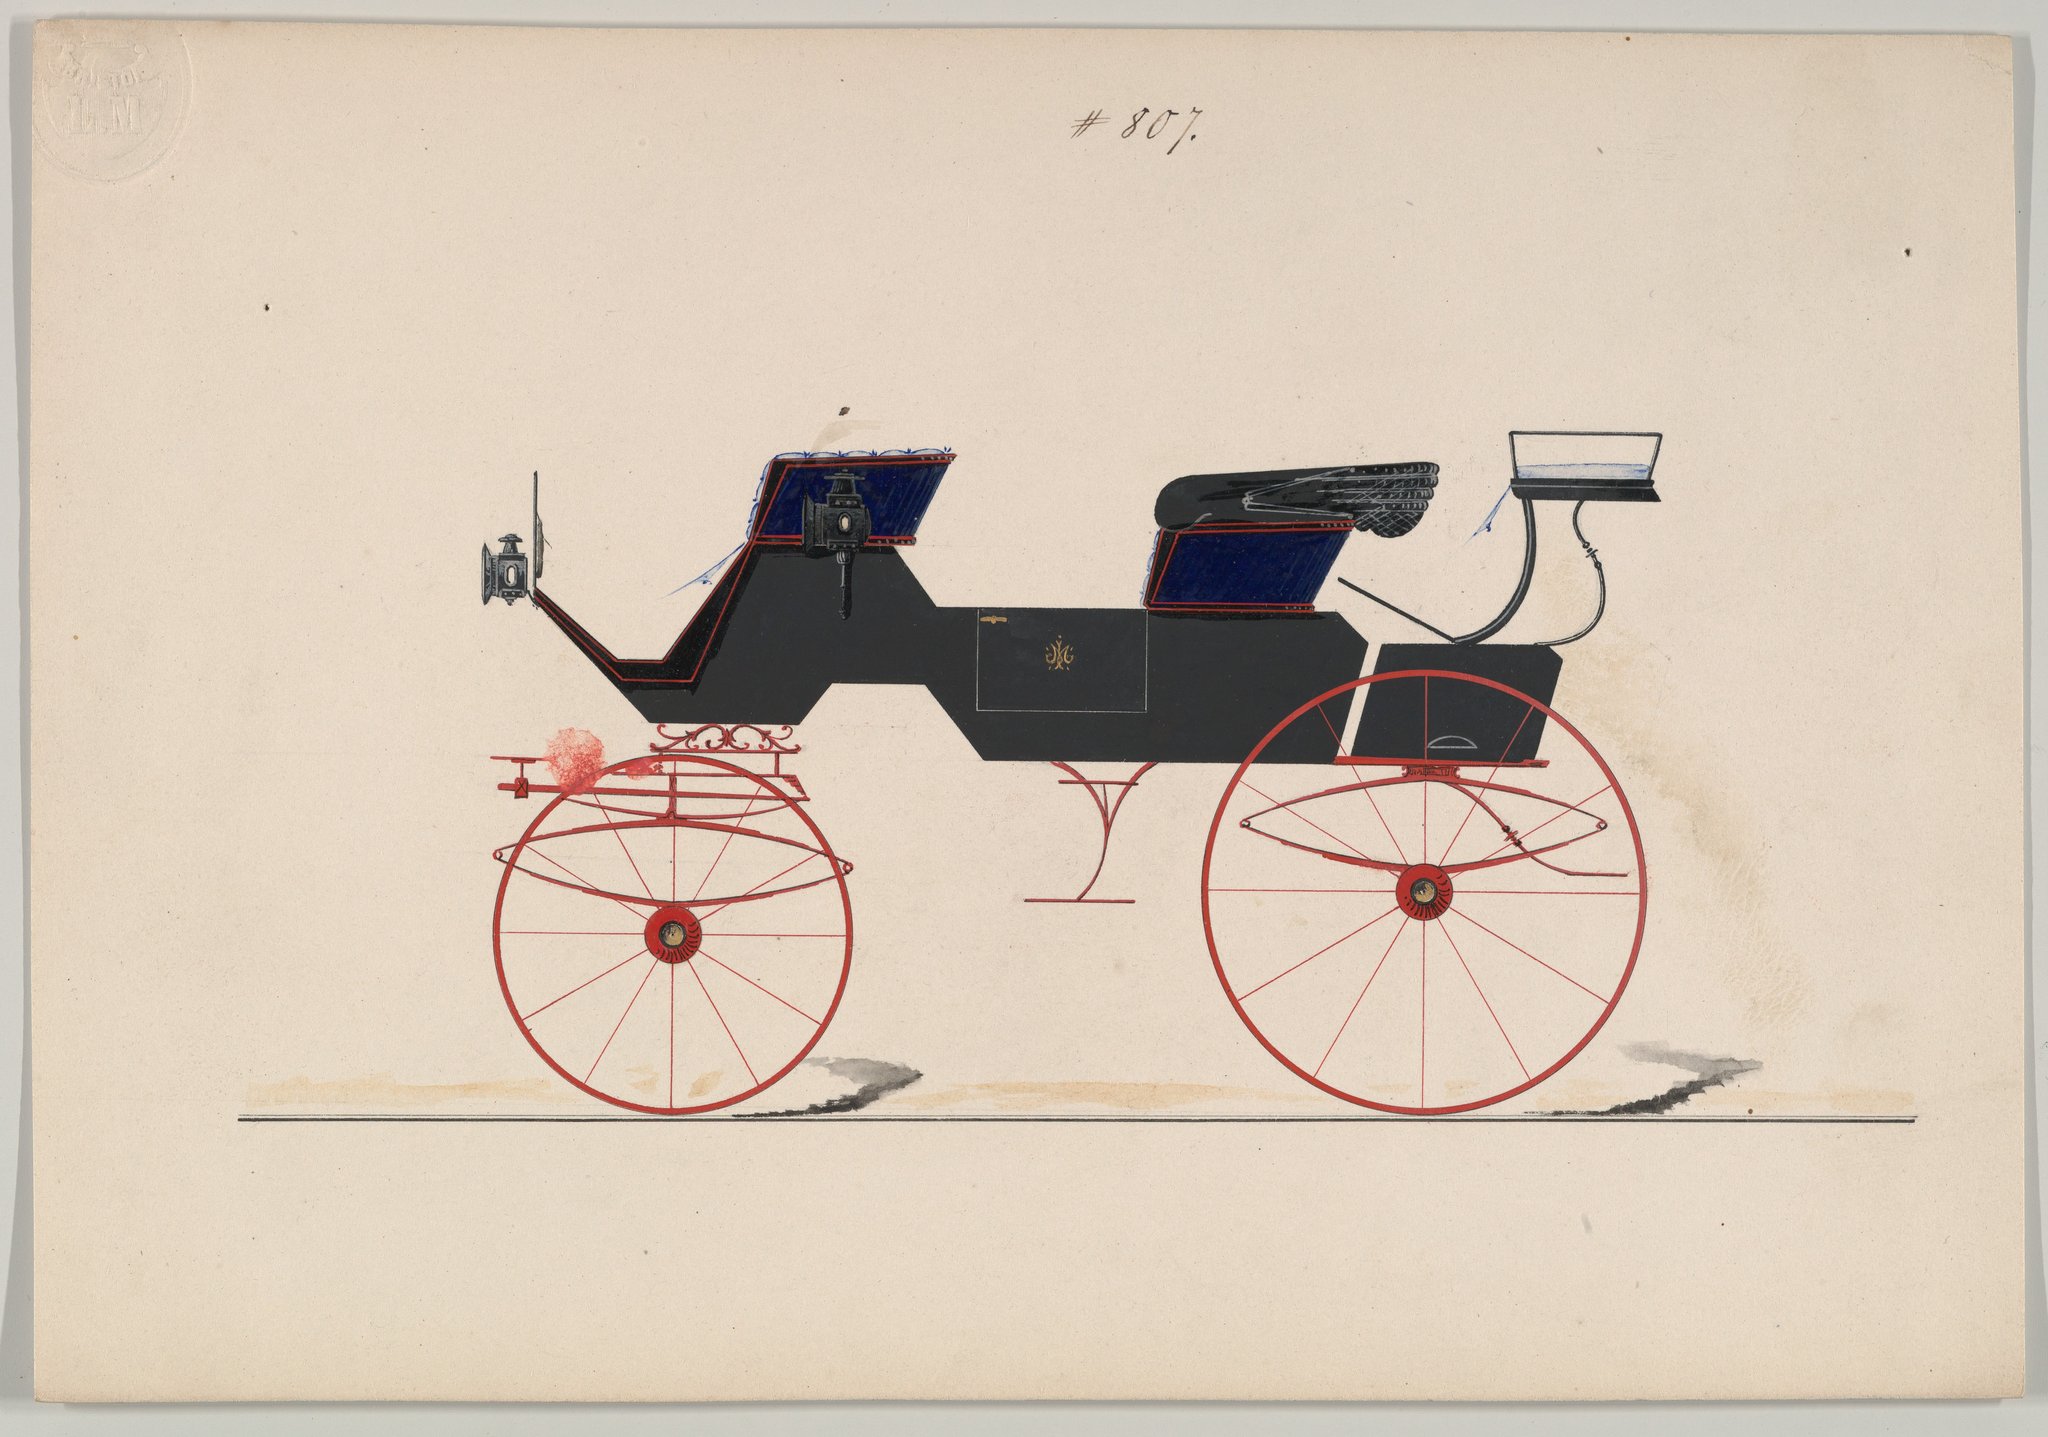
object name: drawing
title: Drag #807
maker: brewster & co.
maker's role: manufacturer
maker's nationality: american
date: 1850-1870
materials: gouache, gum arabic, ink, watercolor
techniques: pen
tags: carriages